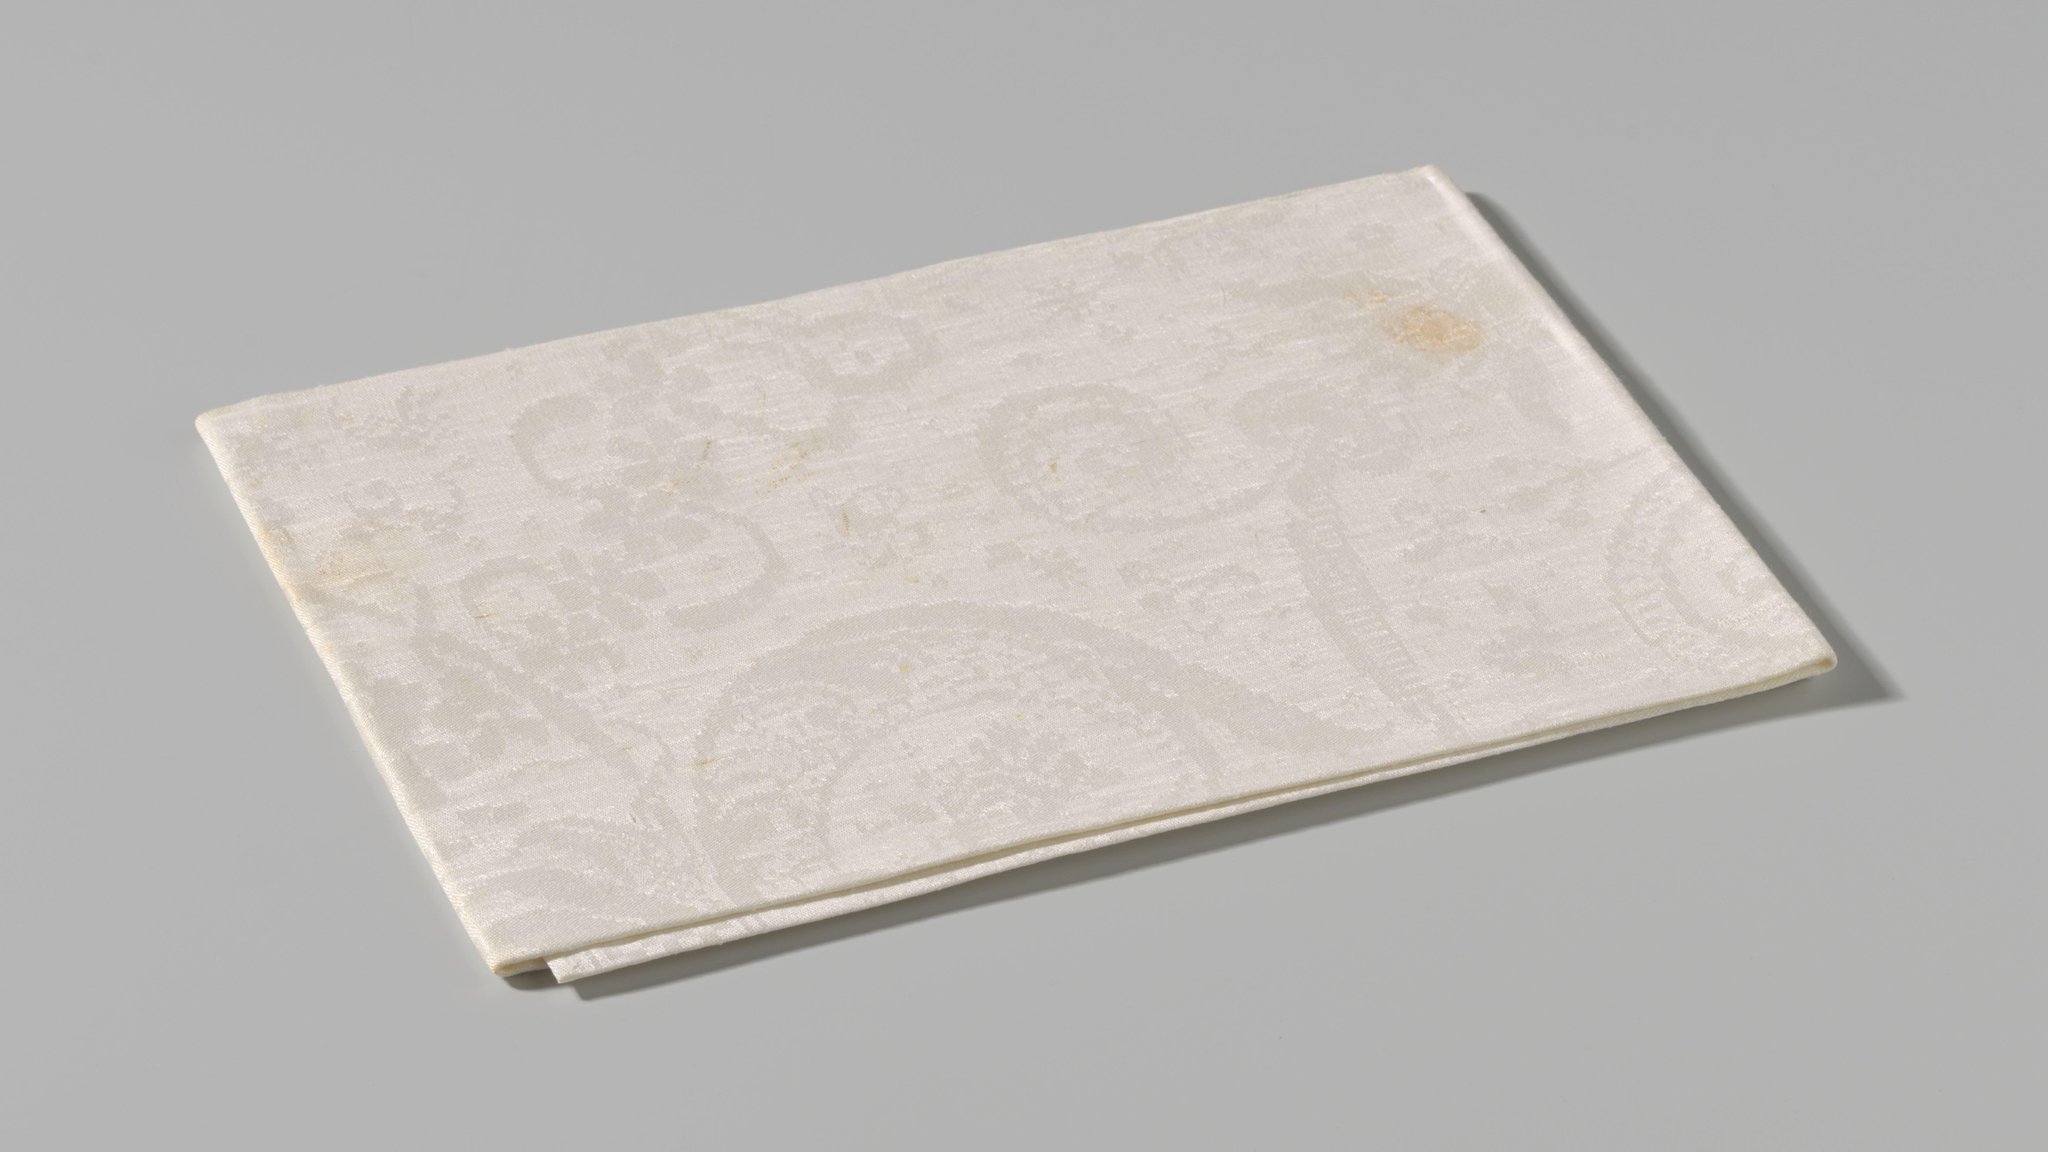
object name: napkin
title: Servet van linnendamast met een bloempatroon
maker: Anonymous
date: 1680-1700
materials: linen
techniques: damask, weave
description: Servet van linnendamast met voluten en gestrooide bloemen. Het servet hoort bij zeven servetten (BK-1973-162-A t/m BK-1973-162-H) en een tafellaken (BK-1973-161).